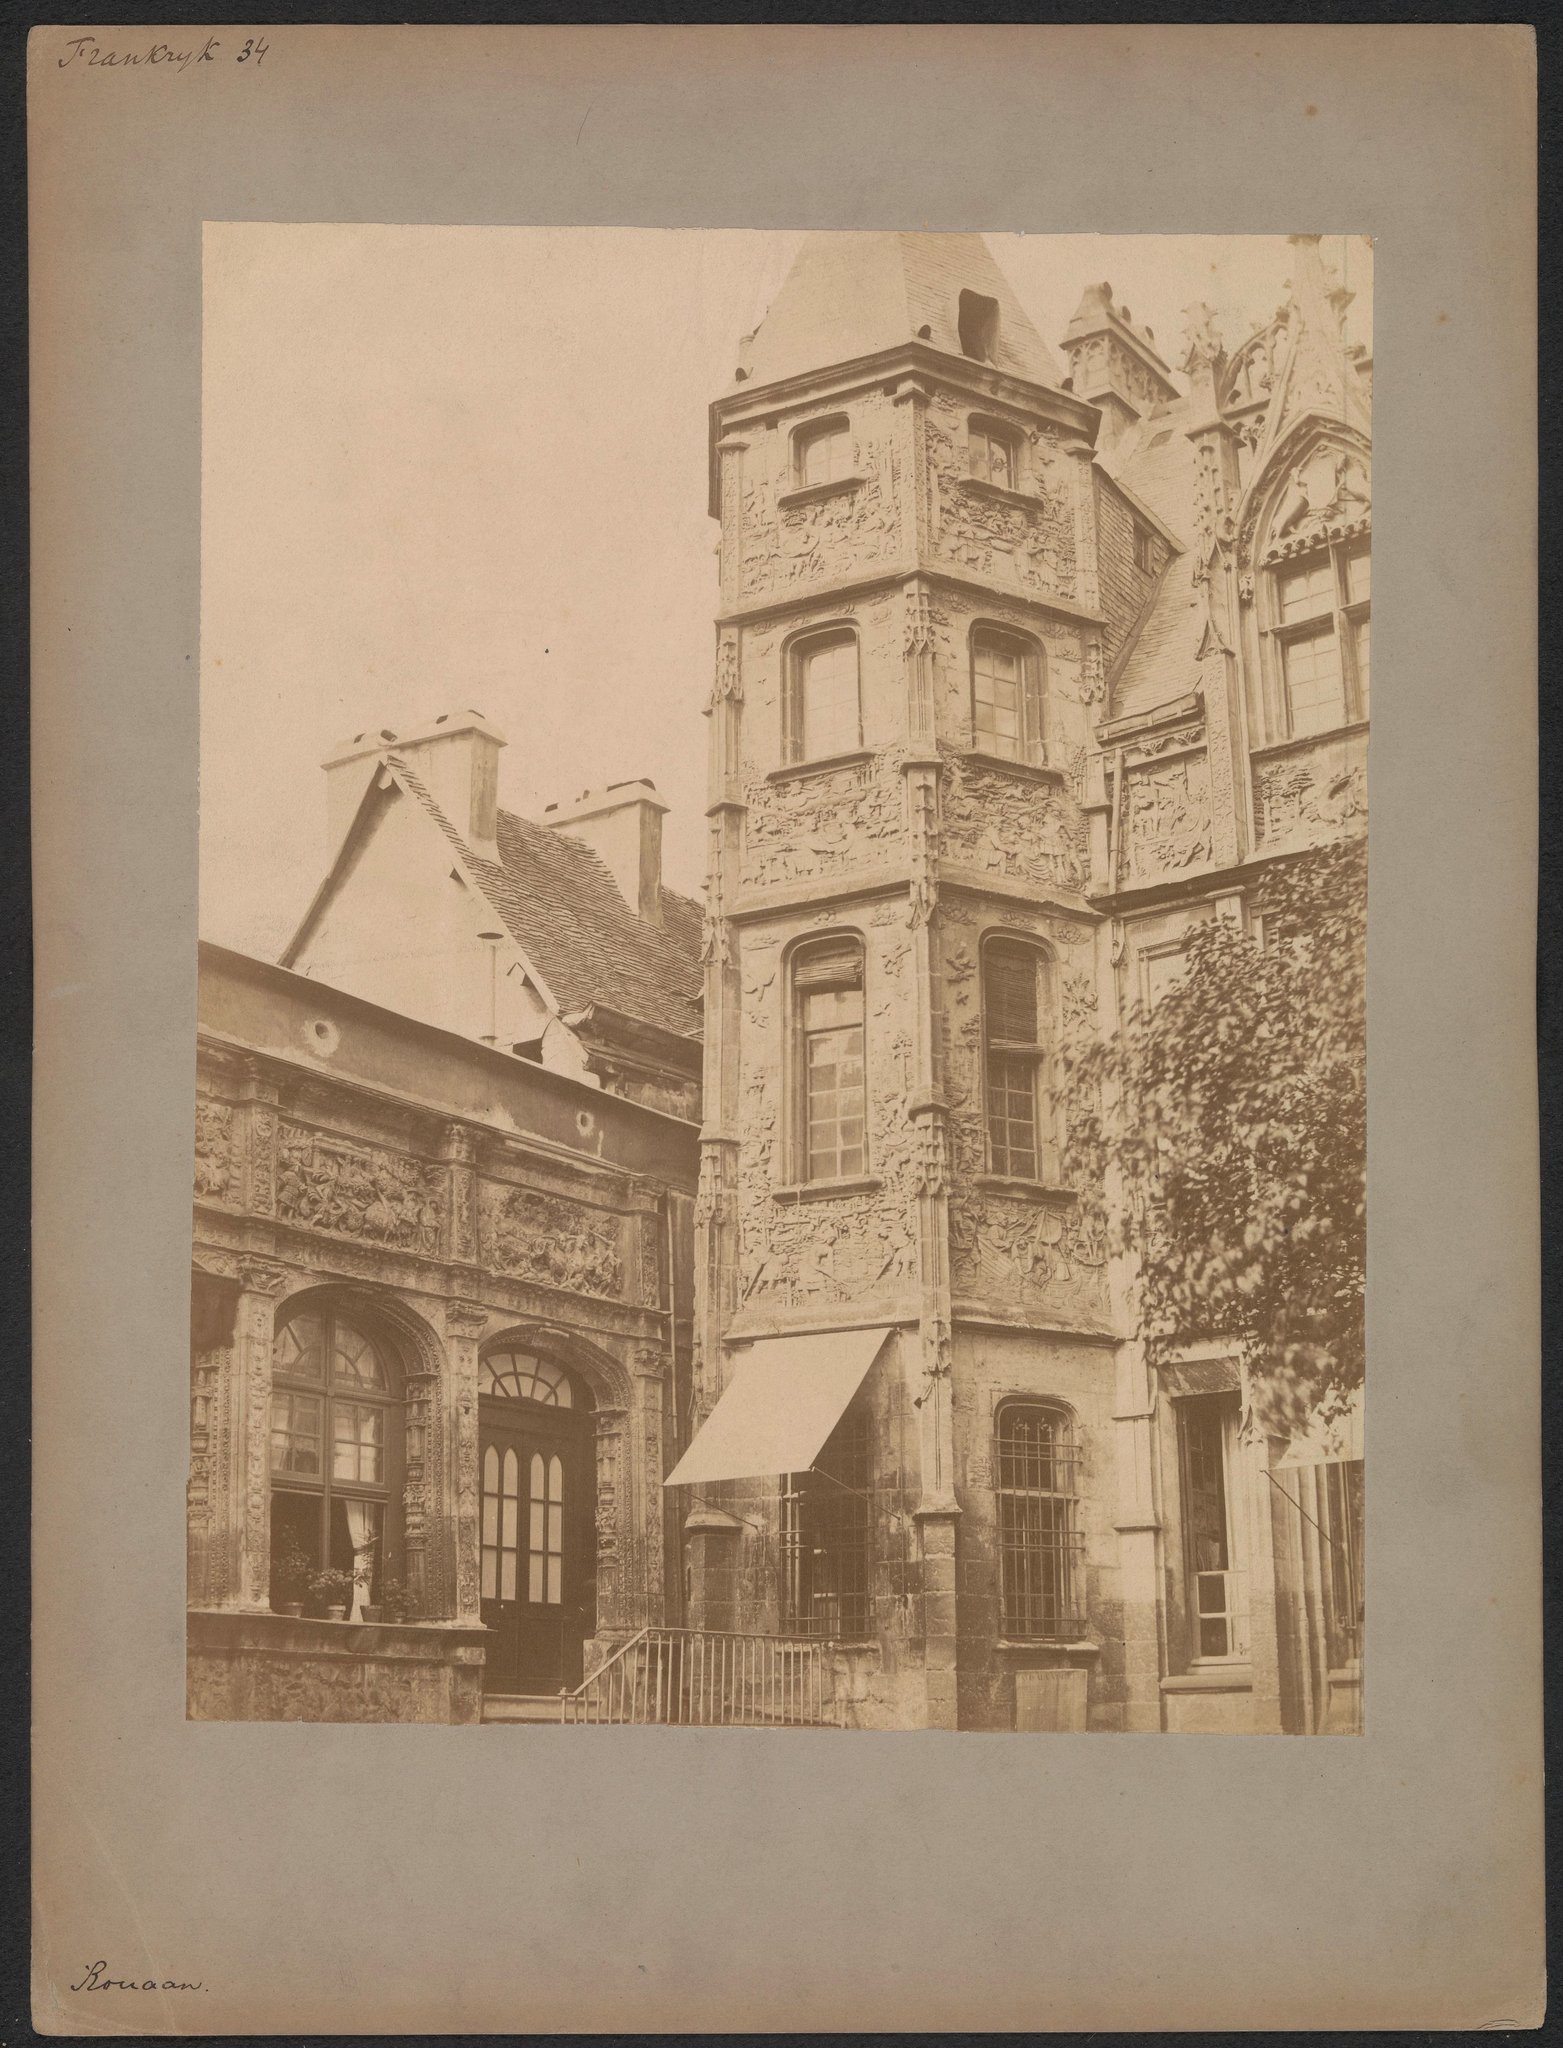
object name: photograph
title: Gezicht op een gebouw in Rouen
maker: Anonymous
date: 1850-1900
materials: cardboard, photographic support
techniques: albumen print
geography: hôtel de bourgtheroulde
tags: housing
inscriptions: annotation: ‘Frankrijk 34’, collector's mark: ‘RIJKS NORMAALSCHOOL voor T[EEKENONDERWIJZERS] AMSTERDAM’, annotation: ‘Rouaan.’